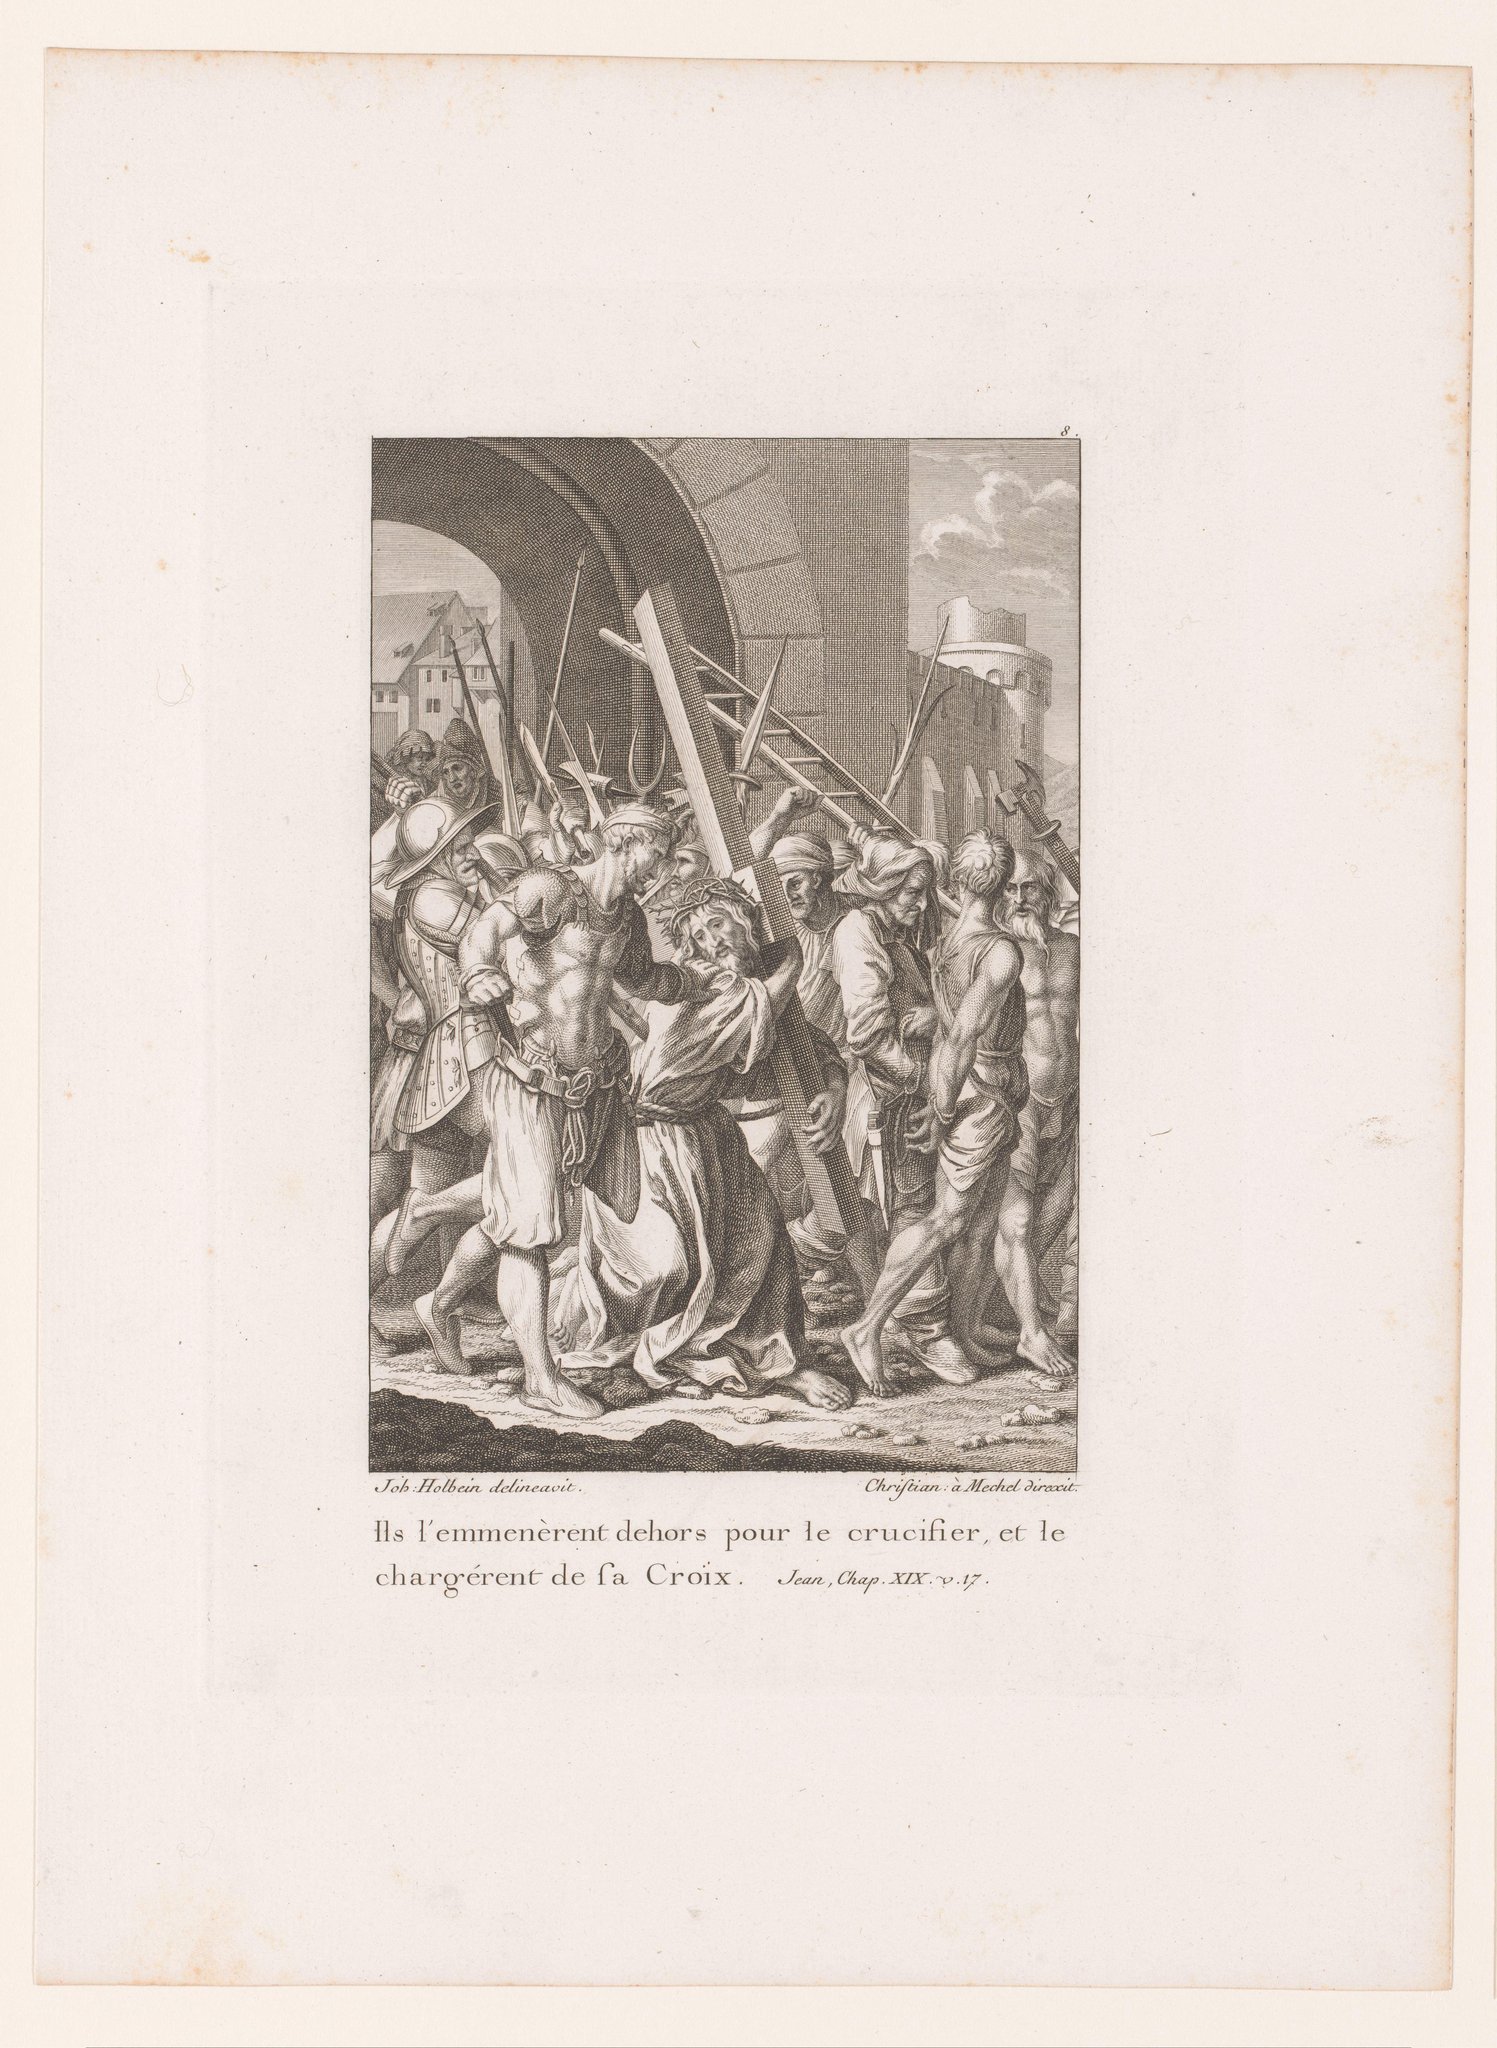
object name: print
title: Passie van Christus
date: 1784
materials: paper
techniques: etching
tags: city-gate, carrying of the cross: christ bearing the cross, alone or with the help of others (e.g. simon the cyrenian)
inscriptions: collector's mark: Lugt 4404, collector's mark: Lugt 2228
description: De serie is deel twee van de vier-delige publicatie 'Oeuvre de Jean Holbein', Bazel 1780-1795, door Christian von Mechel.